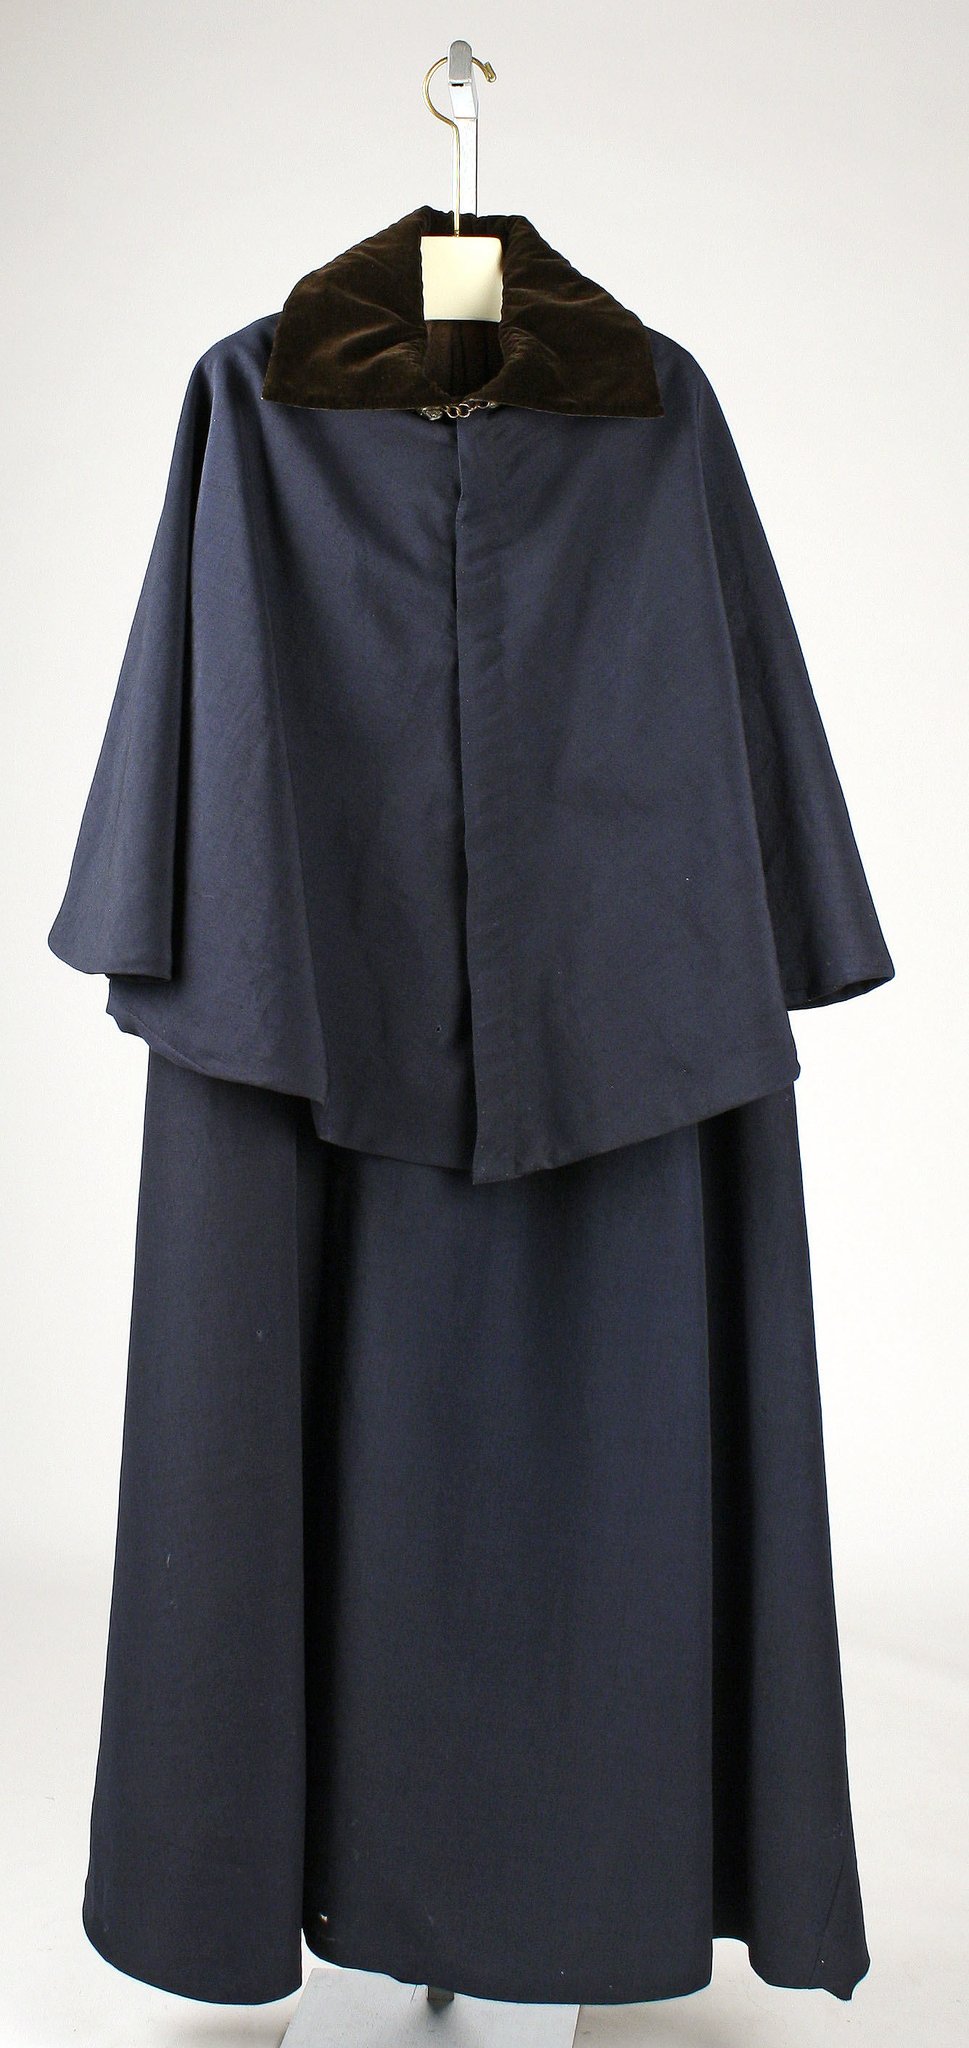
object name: cloak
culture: british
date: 1829-1833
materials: silk, wool